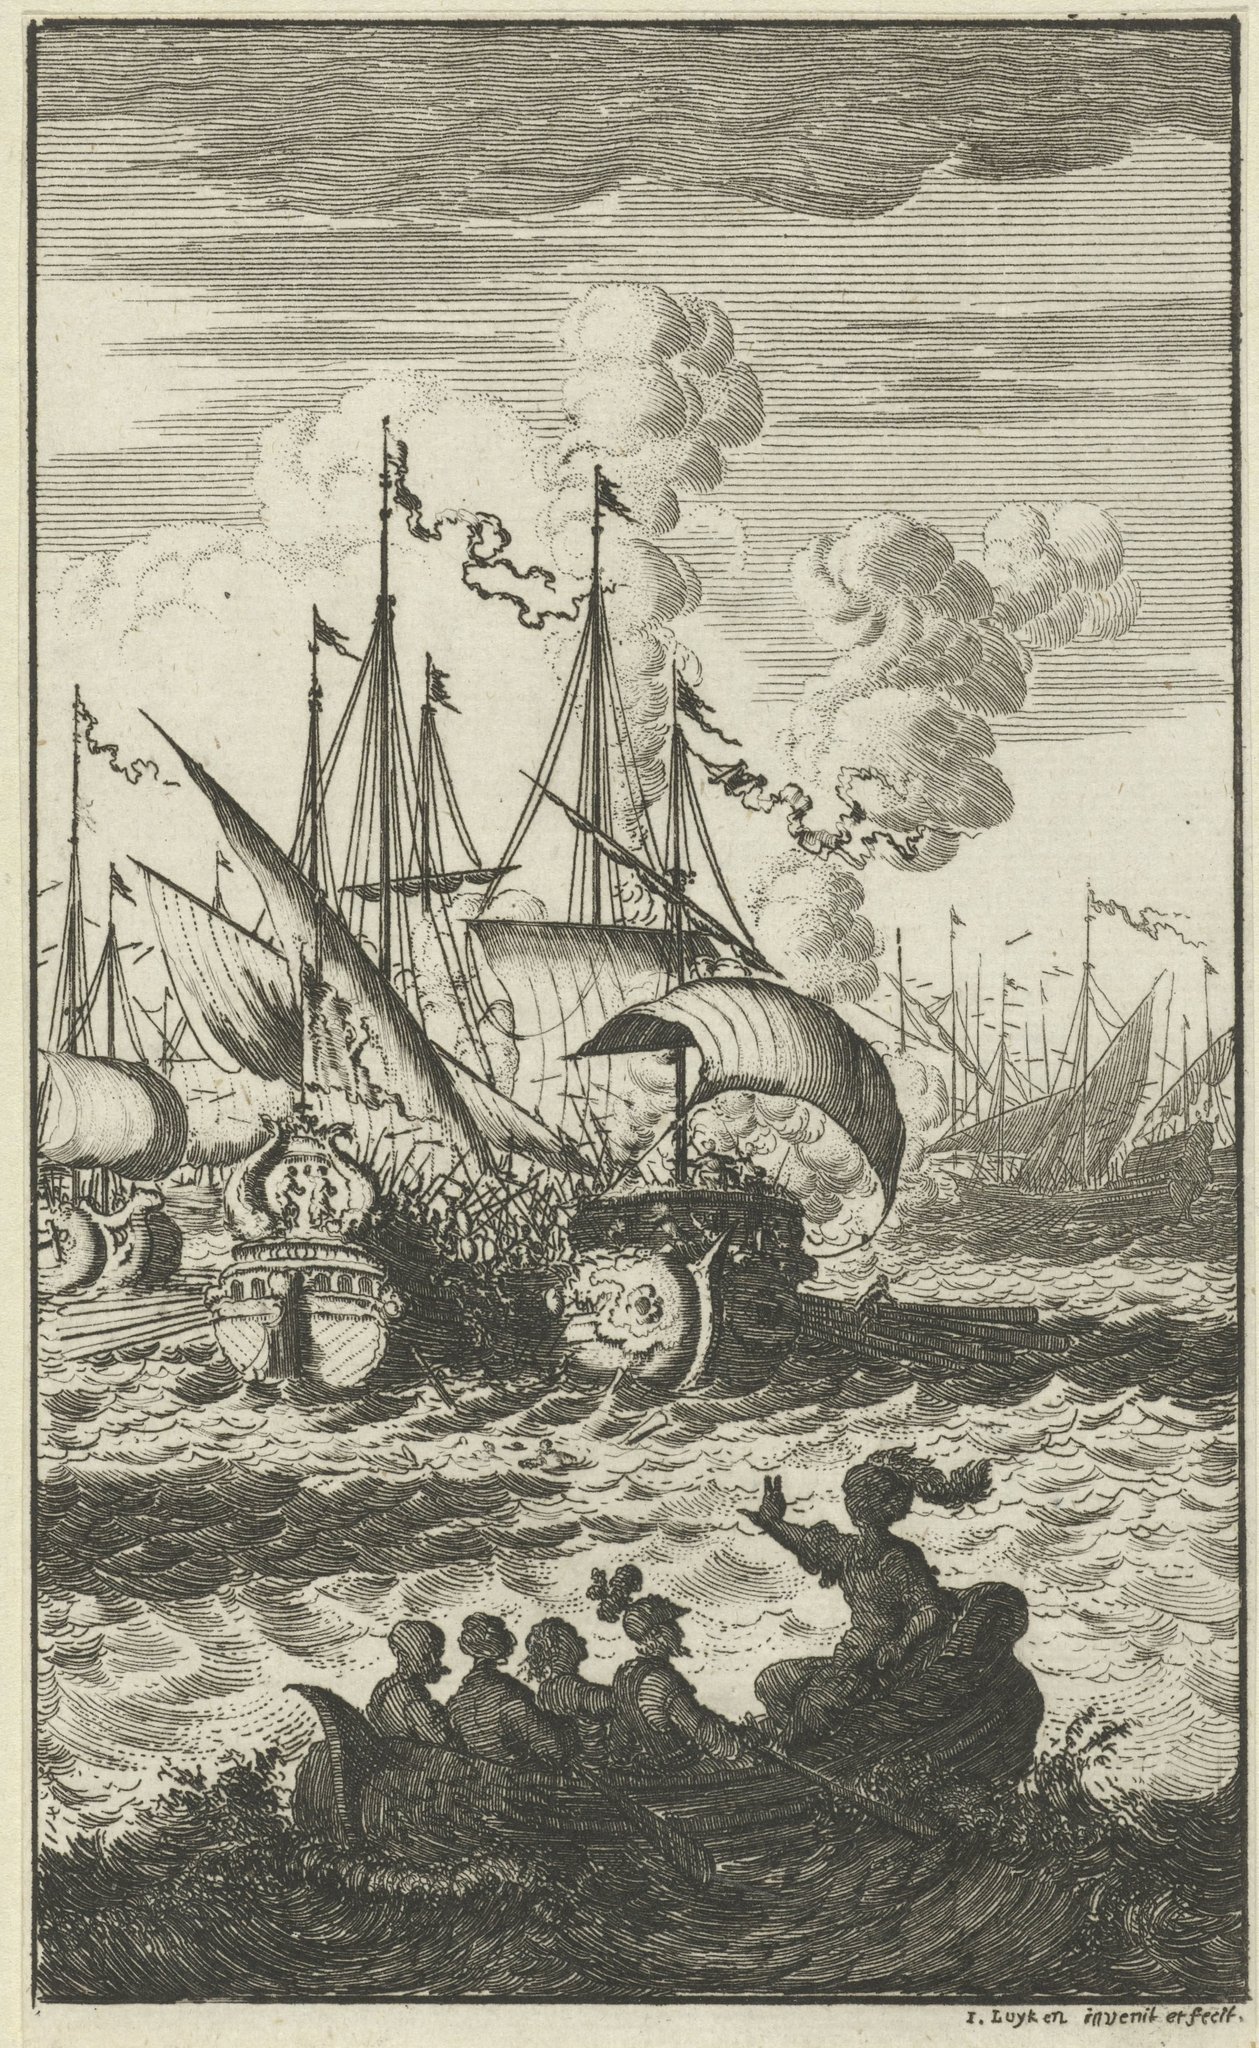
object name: book illustration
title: Ambiodorix ontvlucht de zeeslag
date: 1681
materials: paper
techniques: etching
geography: amsterdam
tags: battle (+ naval force), flight, running away; pursuing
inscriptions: collector's mark: Lugt 240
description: Illustratie opgenomen in het tweede deel van: Barclay, John. D'Argenis, 2 delen. Amsterdam: Jan Claesz ten Hoorn, 1680-1681.